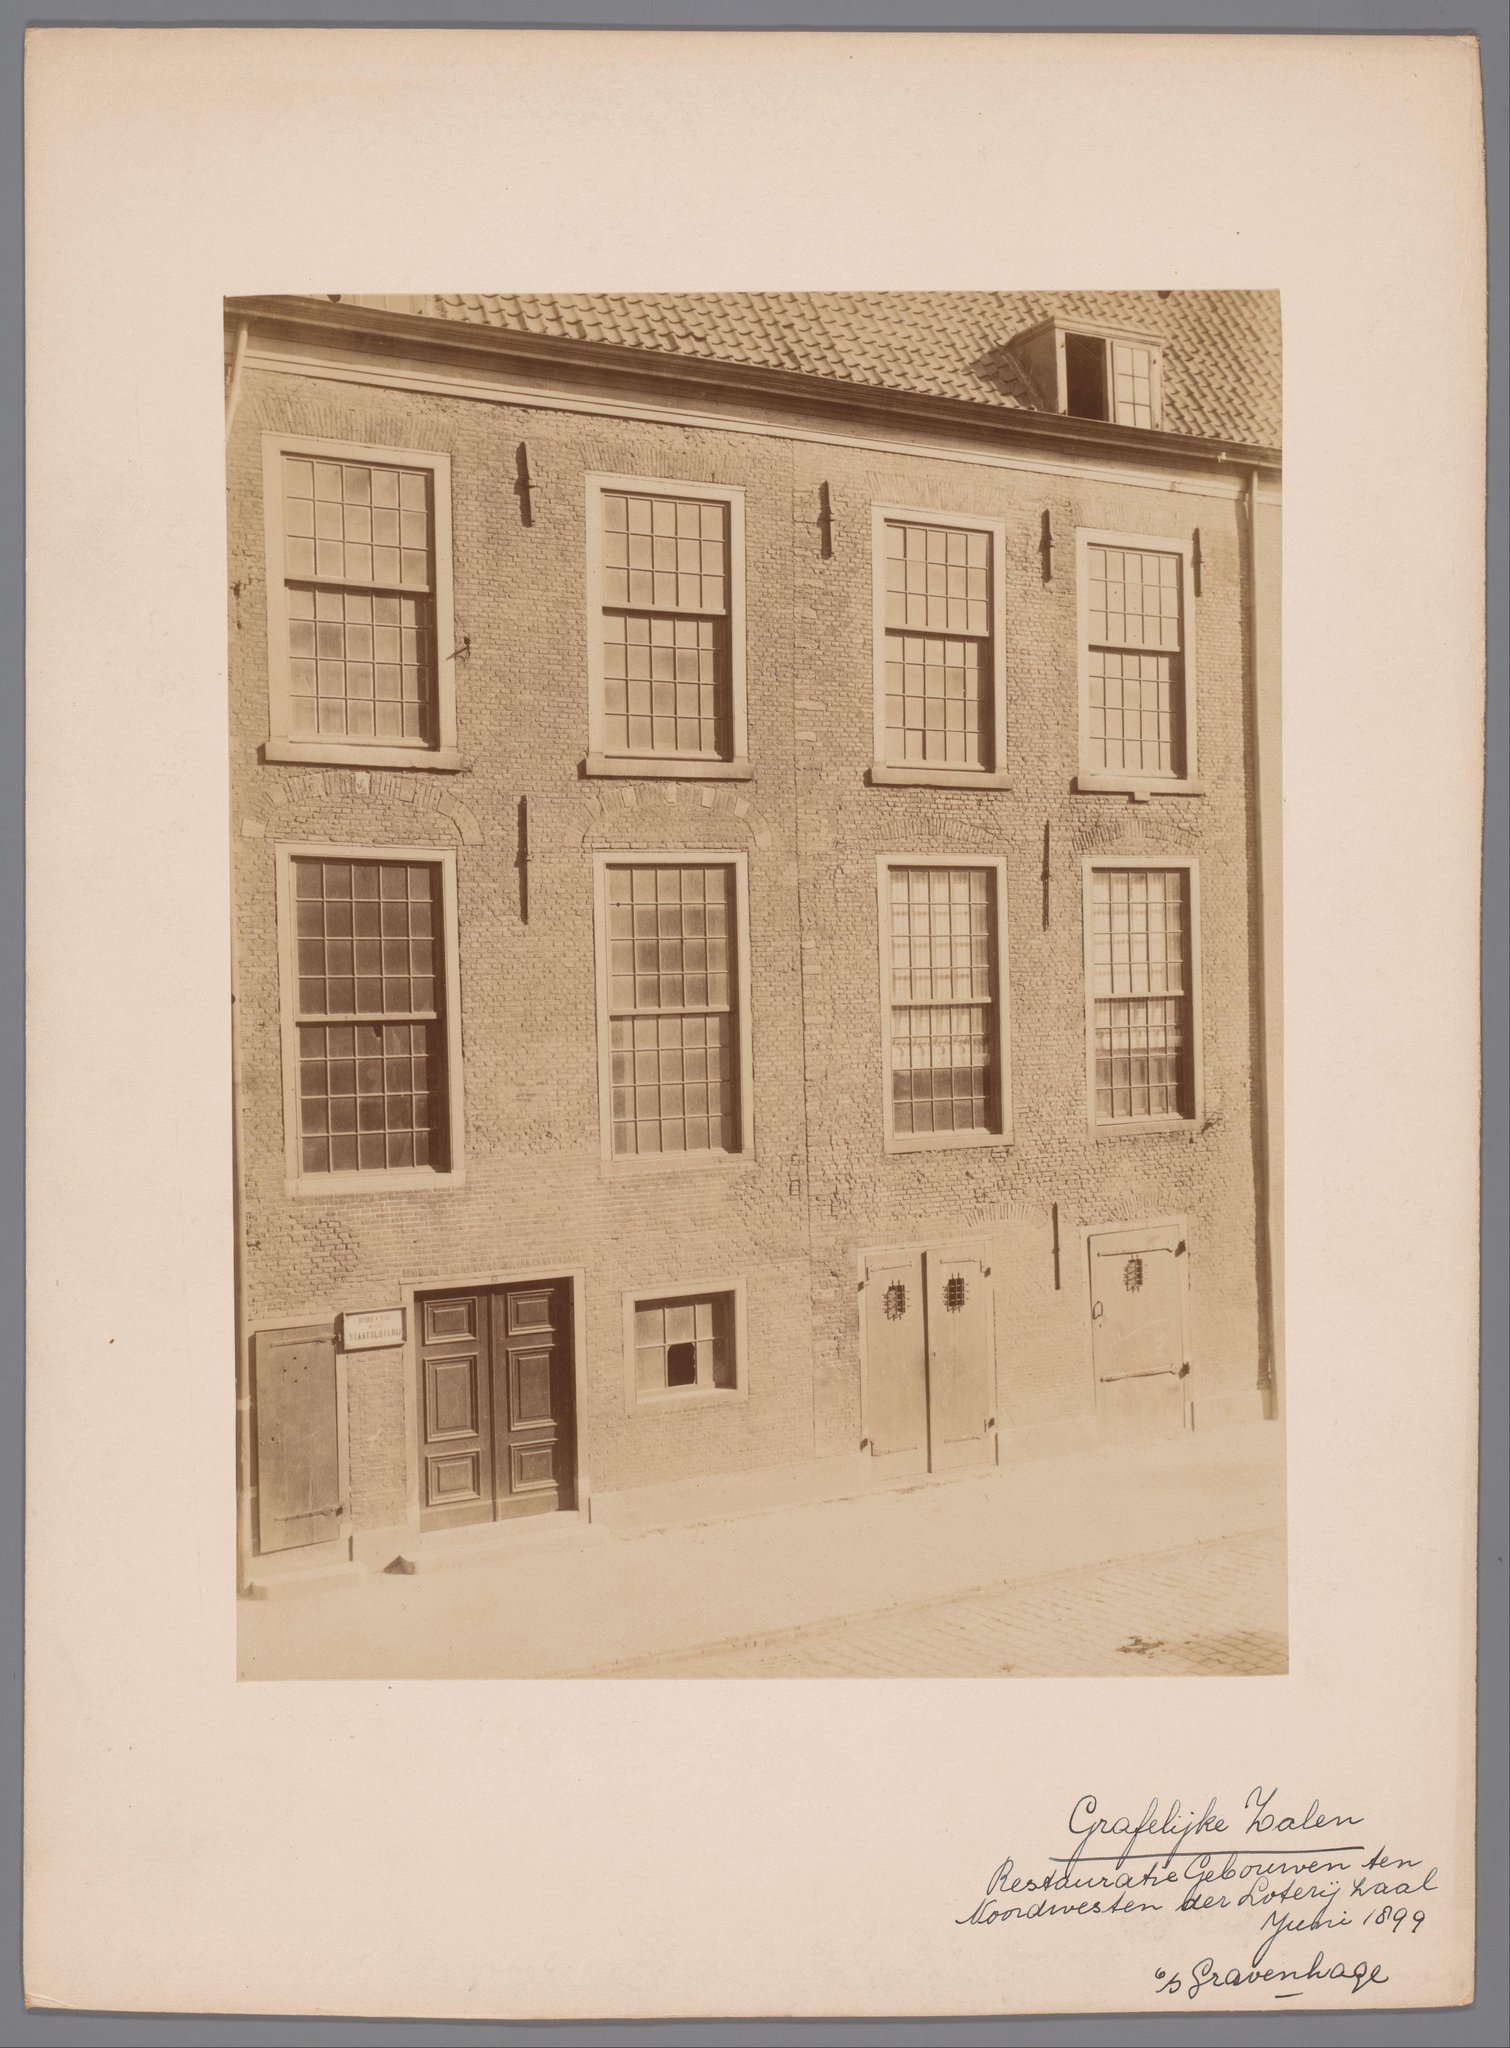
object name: photograph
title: Gezicht op gebouwen aan het Binnenhof tijdens de restauratie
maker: anoniem (monumentenzorg)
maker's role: fotograaf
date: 1899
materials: cardboard, photographic support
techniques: albumen print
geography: binnenhof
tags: courtyard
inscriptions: annotation: ‘'s Gravenhage Binnenhof (Z.H.)/ Gebouwen ten noordwesten der loterijzaal Juni 1899’, annotation: ‘Grafelijke Zalen/ Restauratie gebouwen ten Noordwesten der Loterij Zaal/ Juni 1899/ 's Gravenhage’